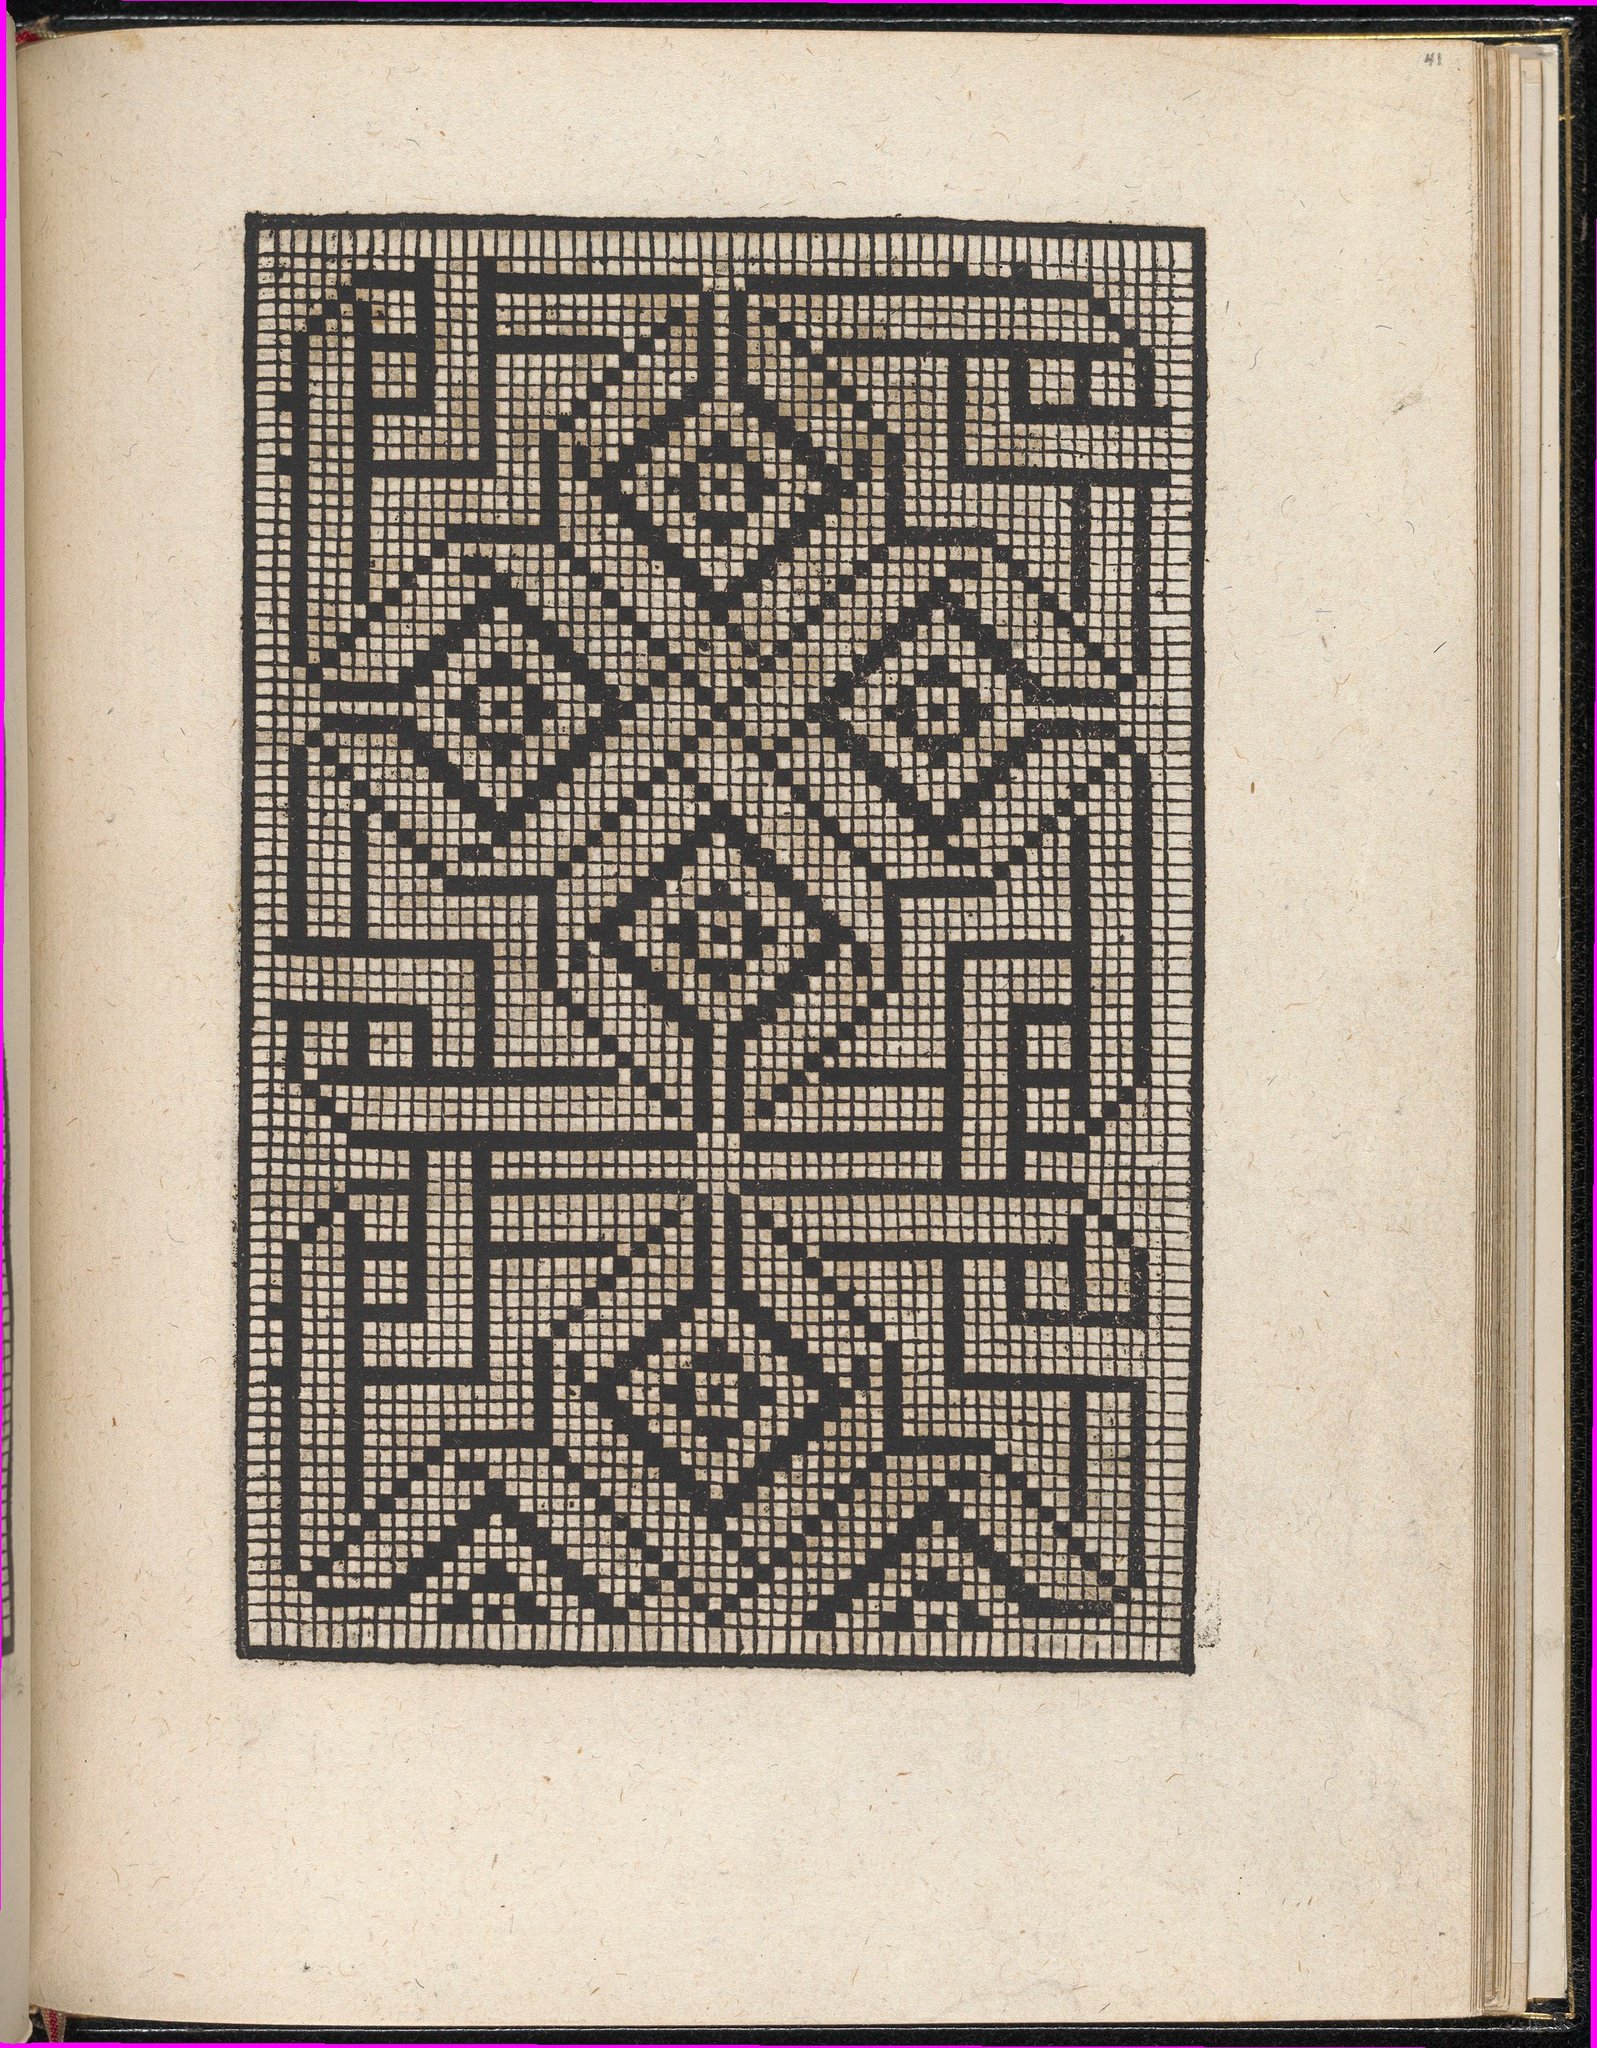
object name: book print ornament architecture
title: Page from Ein new kunstlich Modelbuch...(Page 41r)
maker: peter quentel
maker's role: publisher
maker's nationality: german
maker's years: 1500-1550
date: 1544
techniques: woodcut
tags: ornament